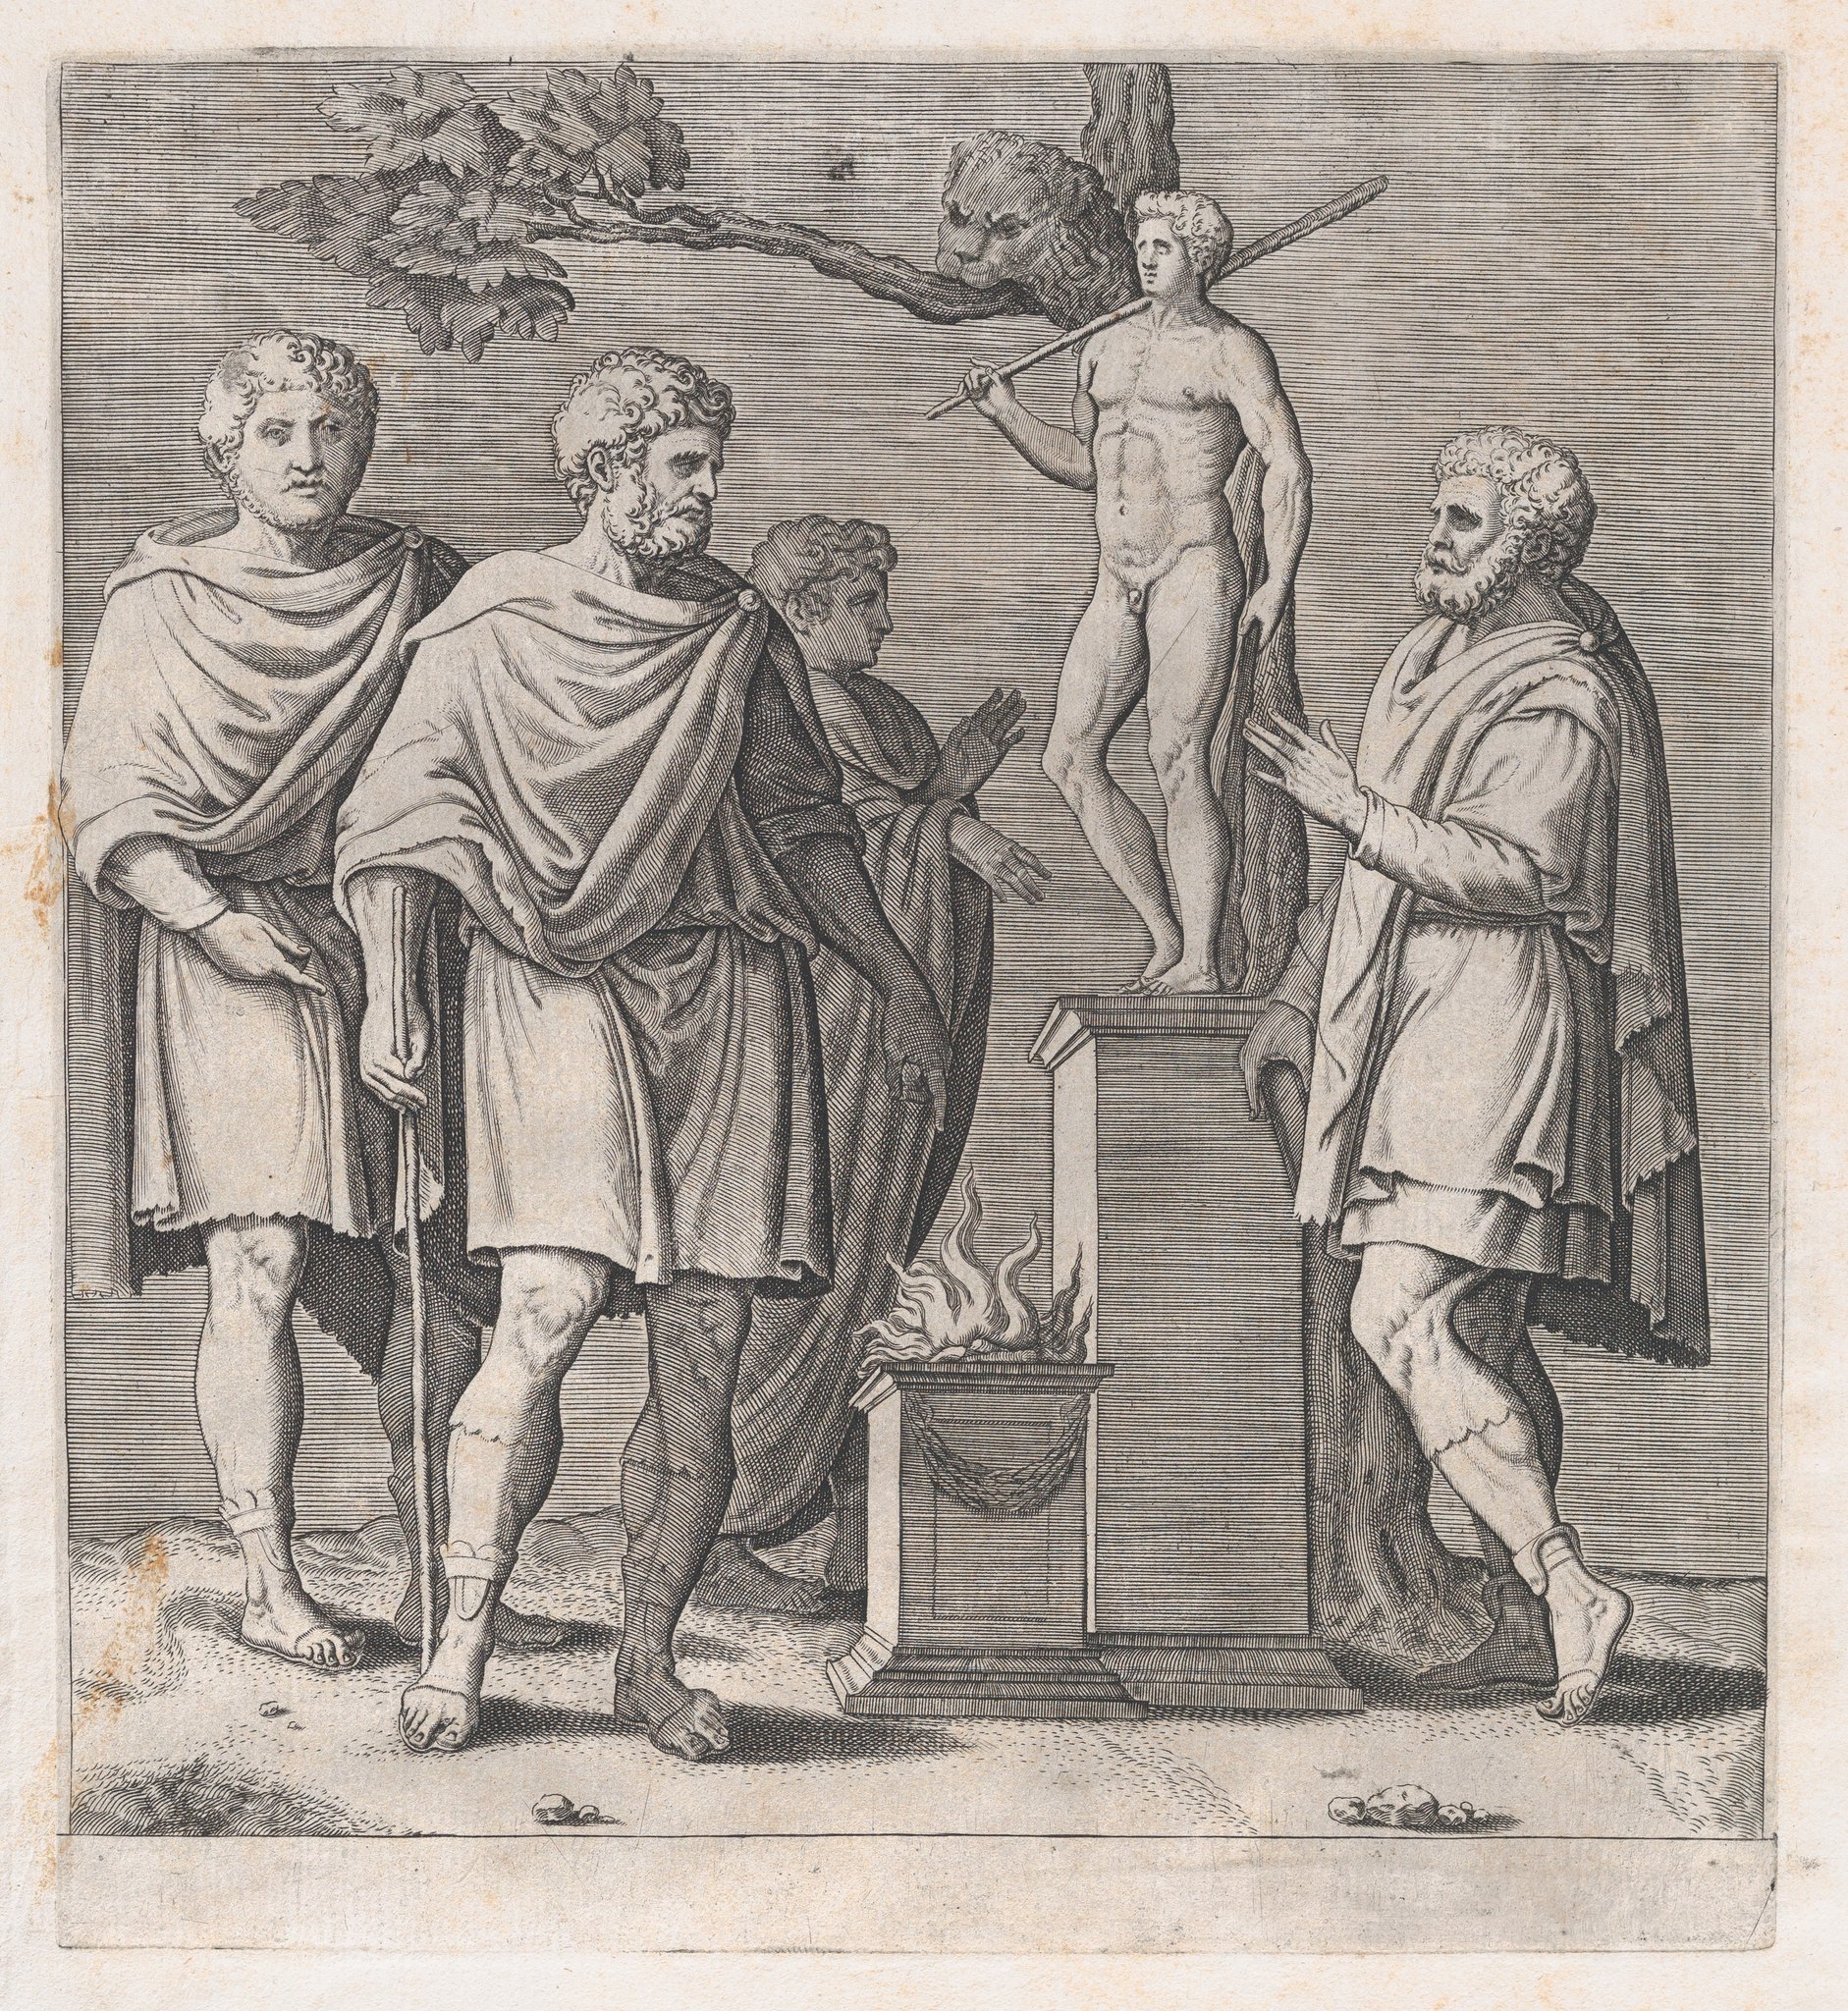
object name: print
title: Sacrifice to Hercules, from "Speculum Romanae Magnificentiae"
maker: Anonymous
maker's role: artist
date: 1501-1600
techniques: etching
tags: men,hercules